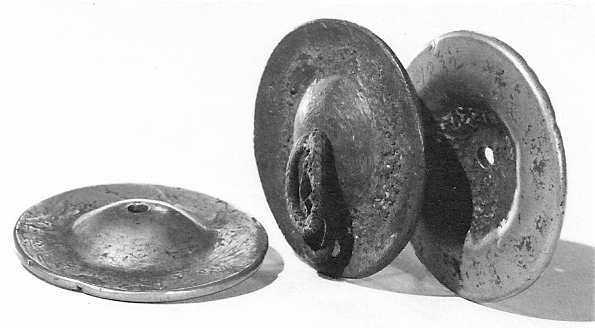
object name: sagat zils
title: Sagat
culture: egyptian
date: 1867-1900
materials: metal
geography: egypt